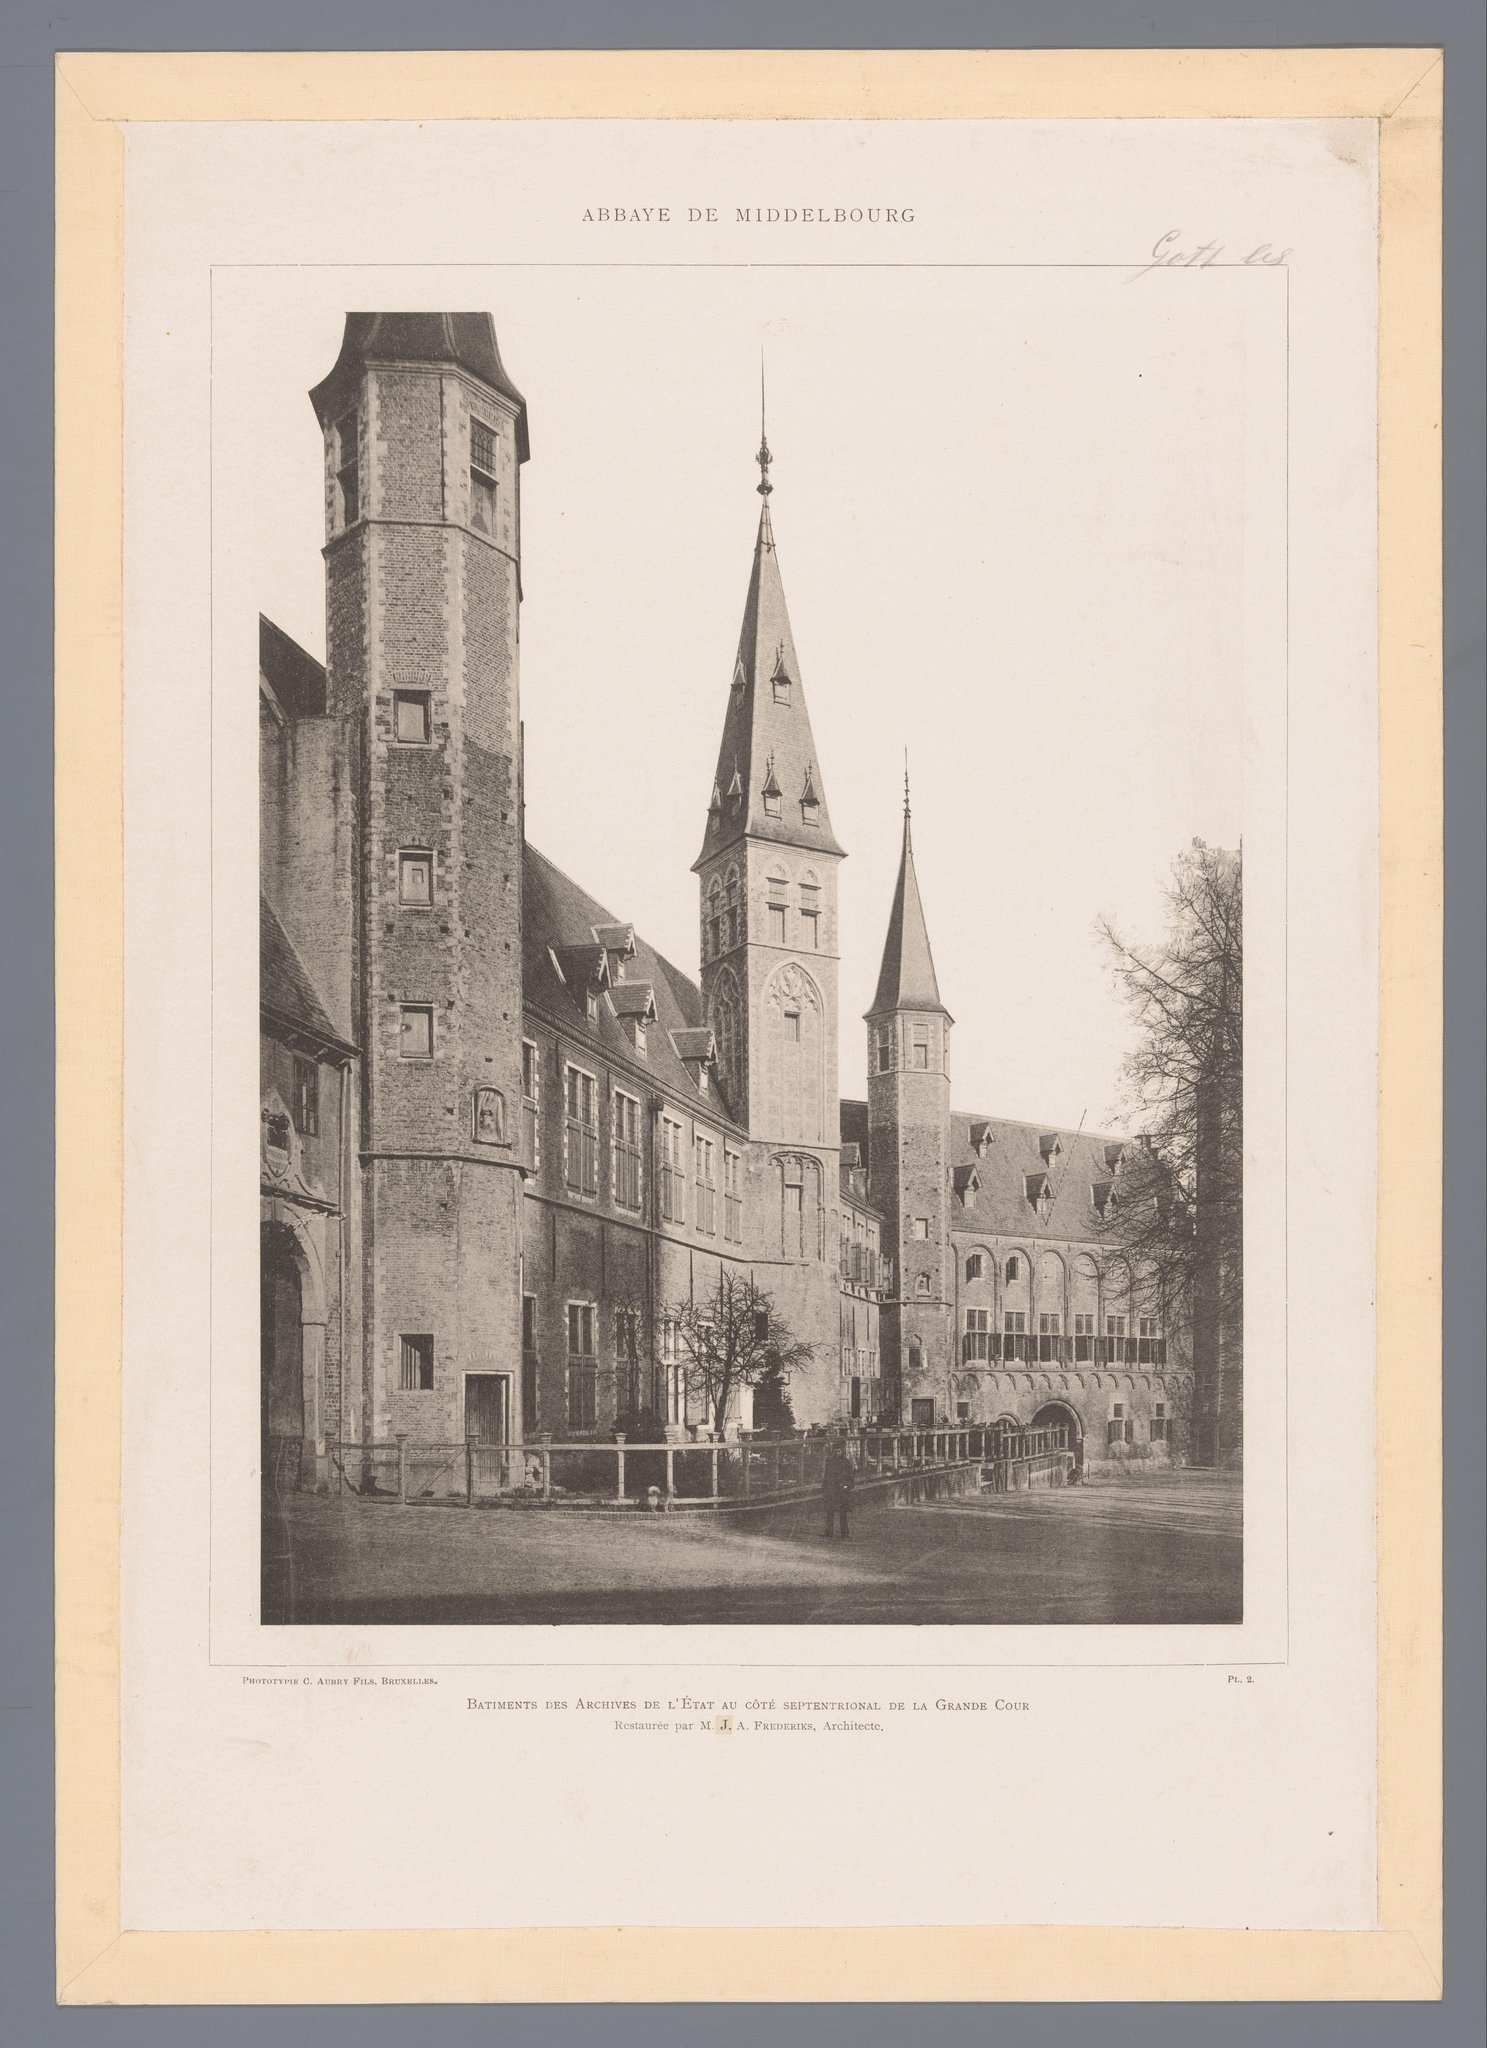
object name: photomechanical print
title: Abdij van Middelburg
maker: Anonymous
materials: paper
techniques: photograph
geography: brussels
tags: abbey, monastery, convent ~ roman catholic church, courtyard